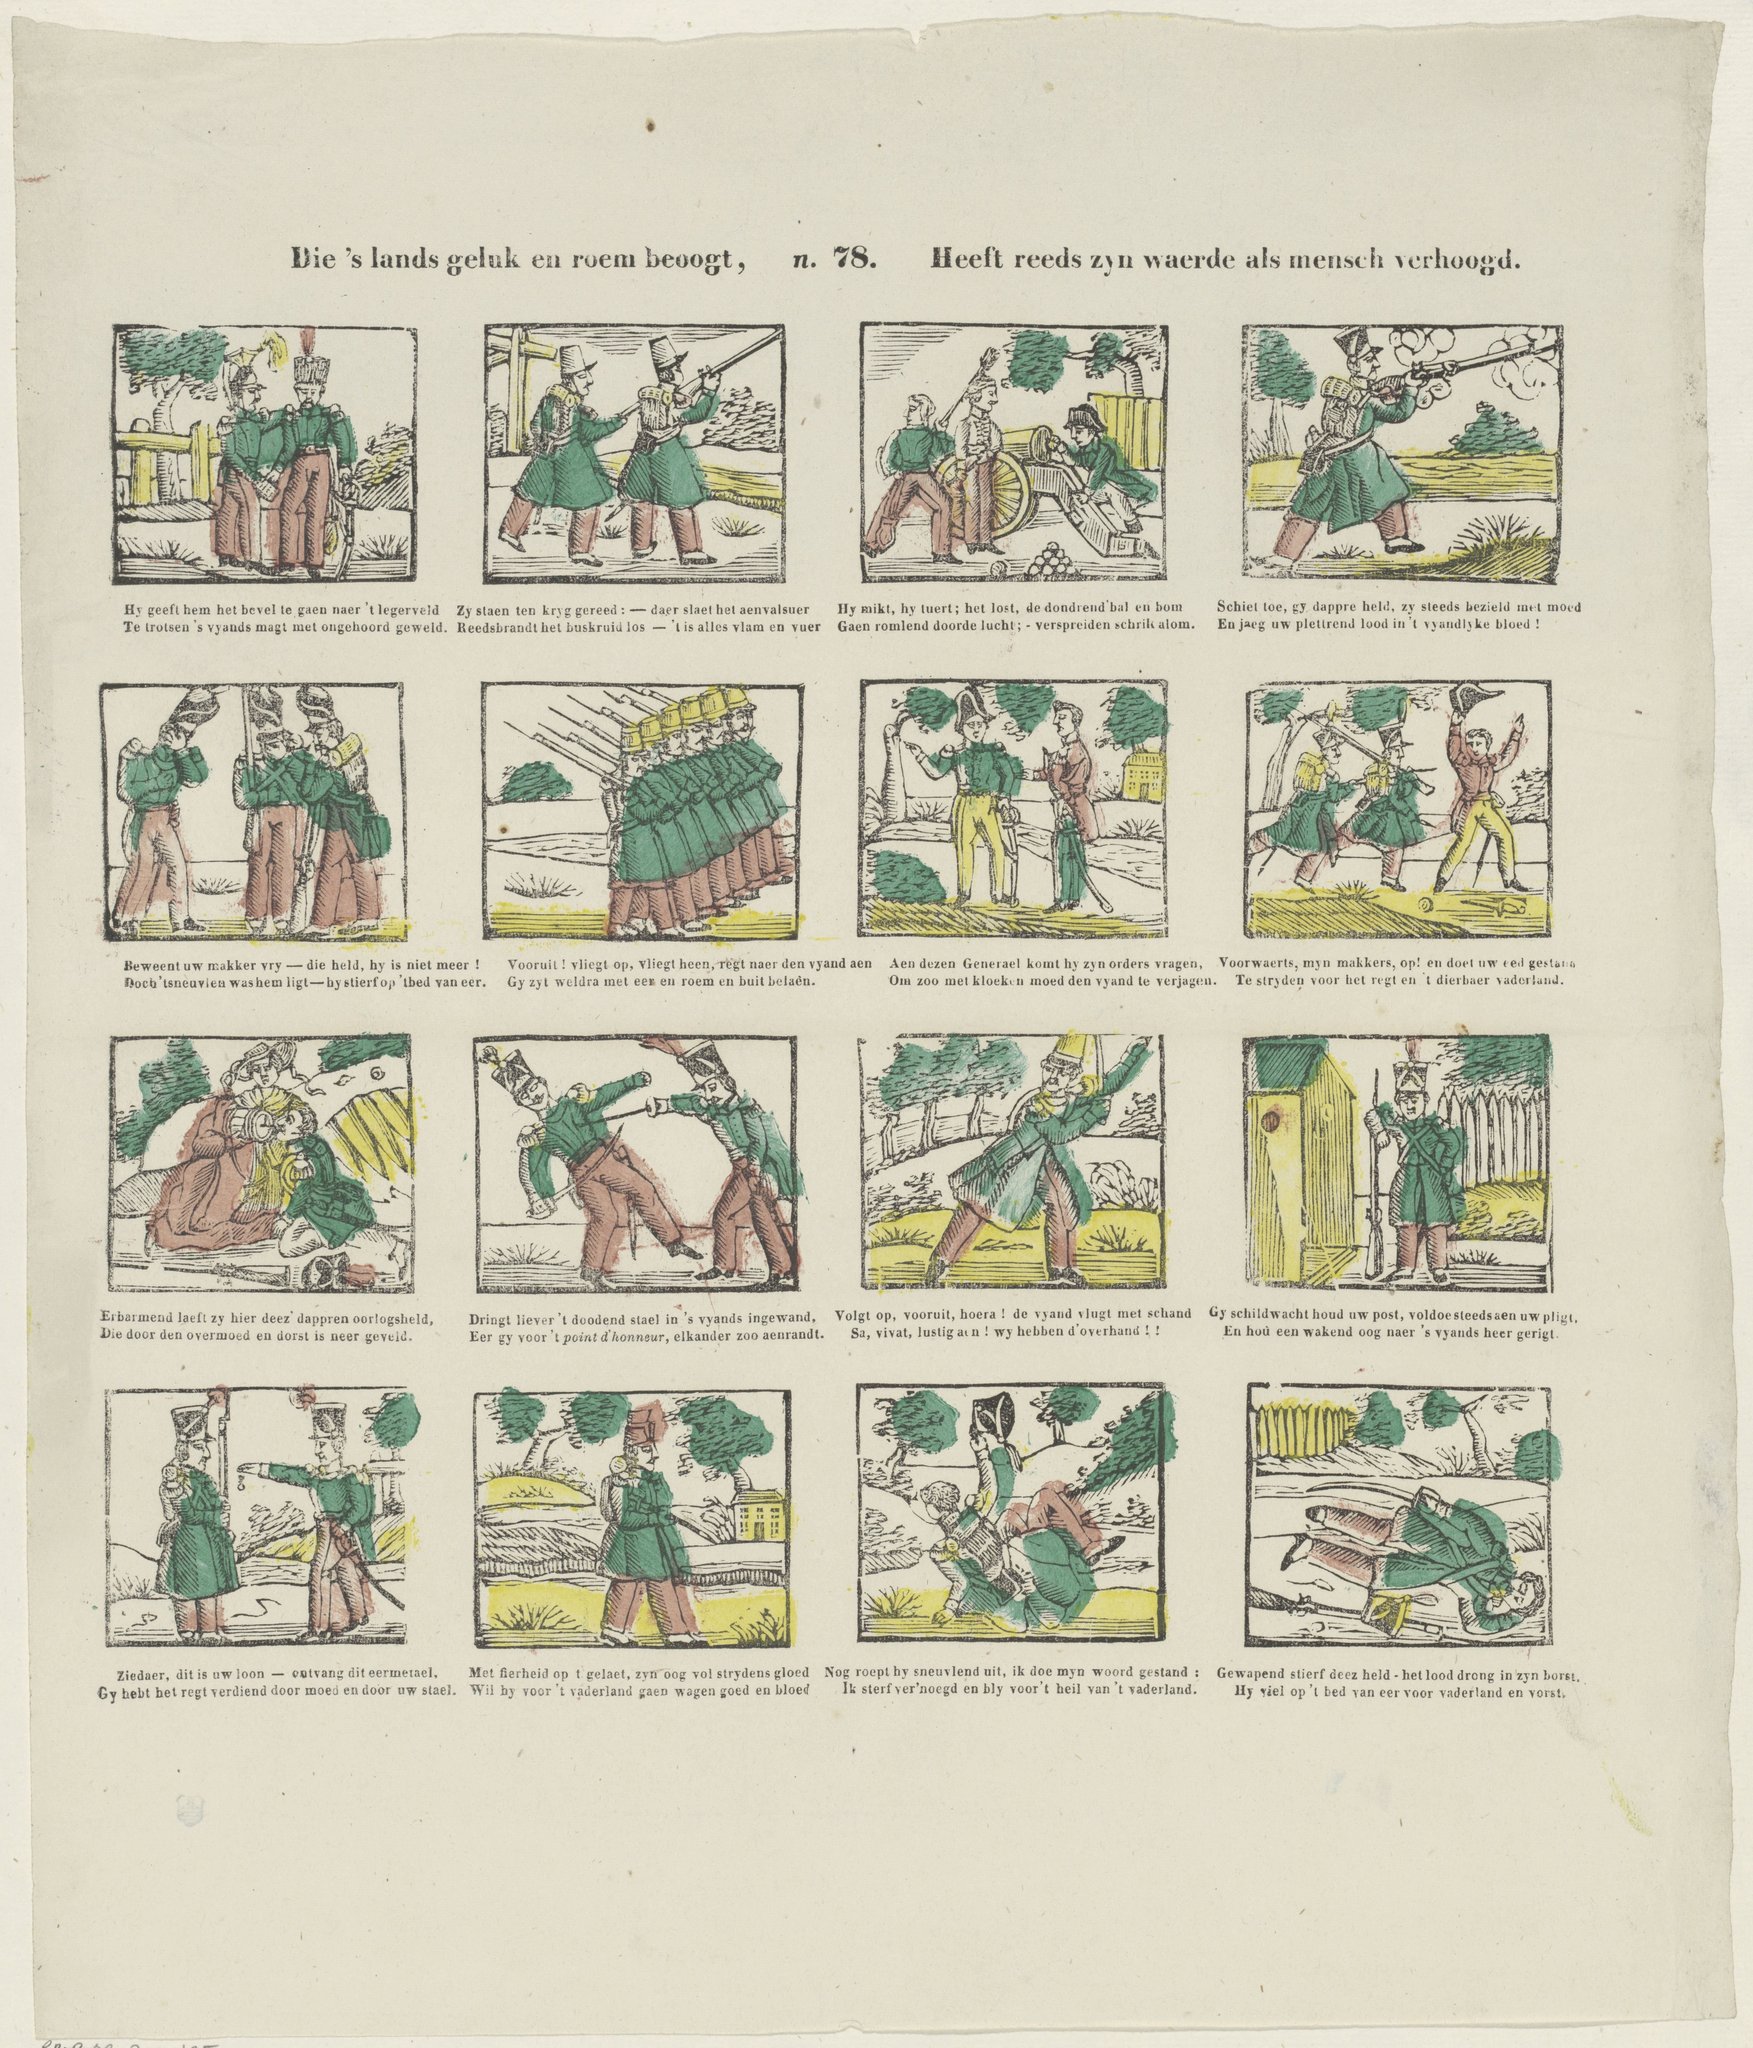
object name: popular print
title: Die 's lands geluk en roem beoogt, / Heeft reeds zyn waerde als mensch verhoogd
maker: Anonymous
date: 1856-1900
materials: paper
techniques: colour, letterpress printing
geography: turnhout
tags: the soldier; the soldier's life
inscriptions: collector's mark: Lugt 2760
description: Blad met 16 voorstellingen over het leven van militairen. Onder elke afbeelding een onderschrift. Genummerd midden boven: n. 78.